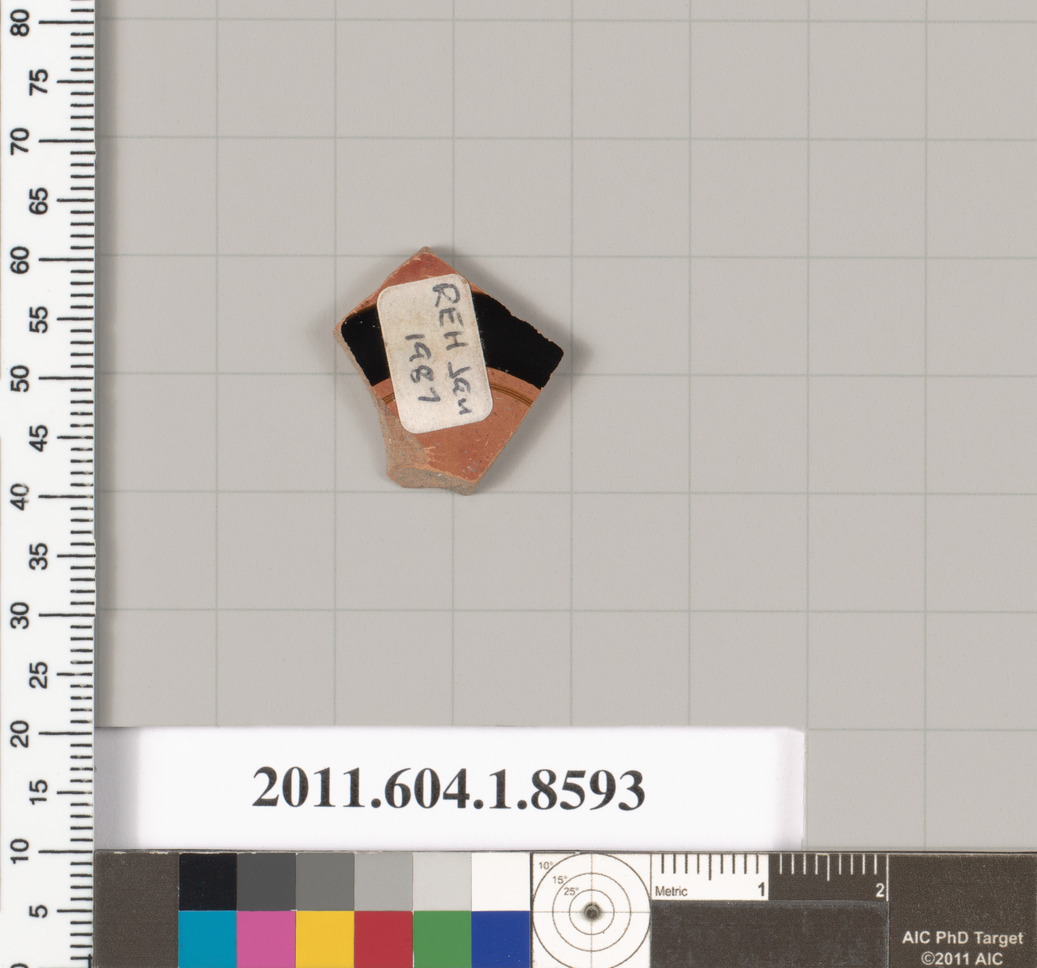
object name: kylix fragment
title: Terracotta fragment of a stemless kylix (drinking cup)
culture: greek, attic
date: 470-450 BCE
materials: terracotta